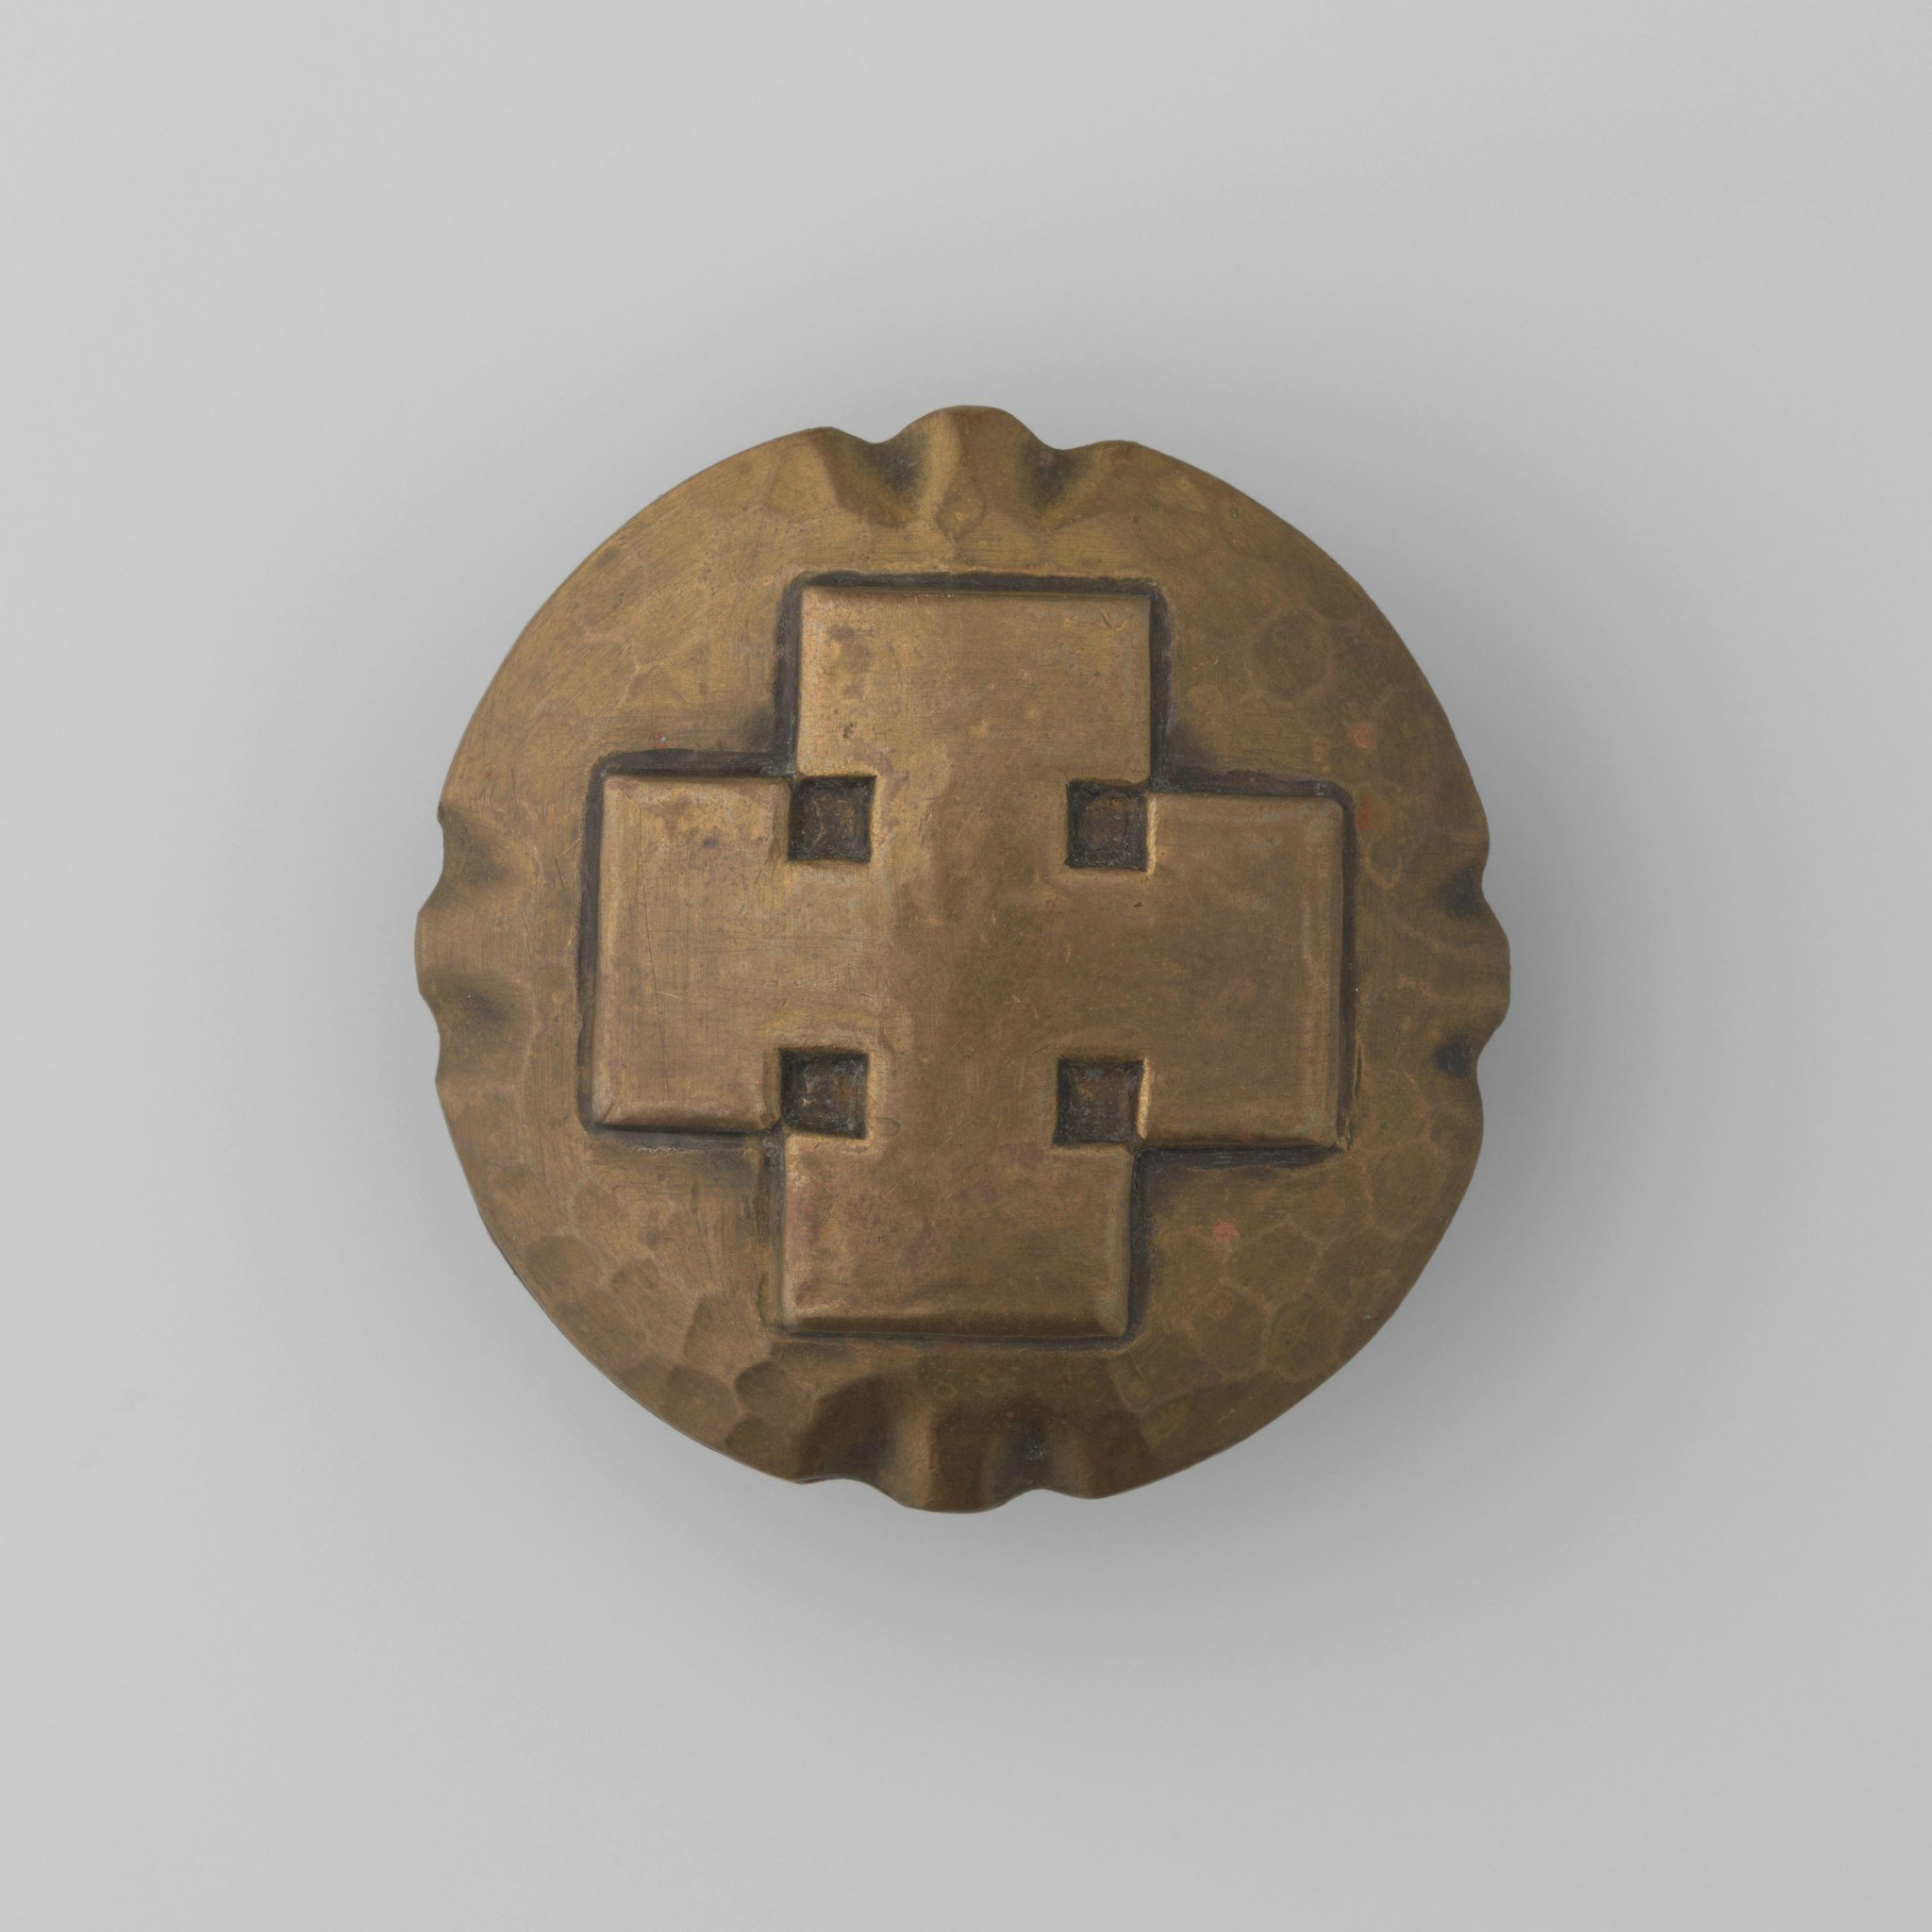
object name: brooch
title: Ronde broche van onedel metaal met Bourgondisch kruis in reliëf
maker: Anonymous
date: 1940-1945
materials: metal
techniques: hammering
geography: netherlands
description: Ronde convexe broche van onedel gehamerd goudkleurig metaal met Bourgondisch kruis (of krukkenkruis) in reliëf voorzien van een haaksluiting.